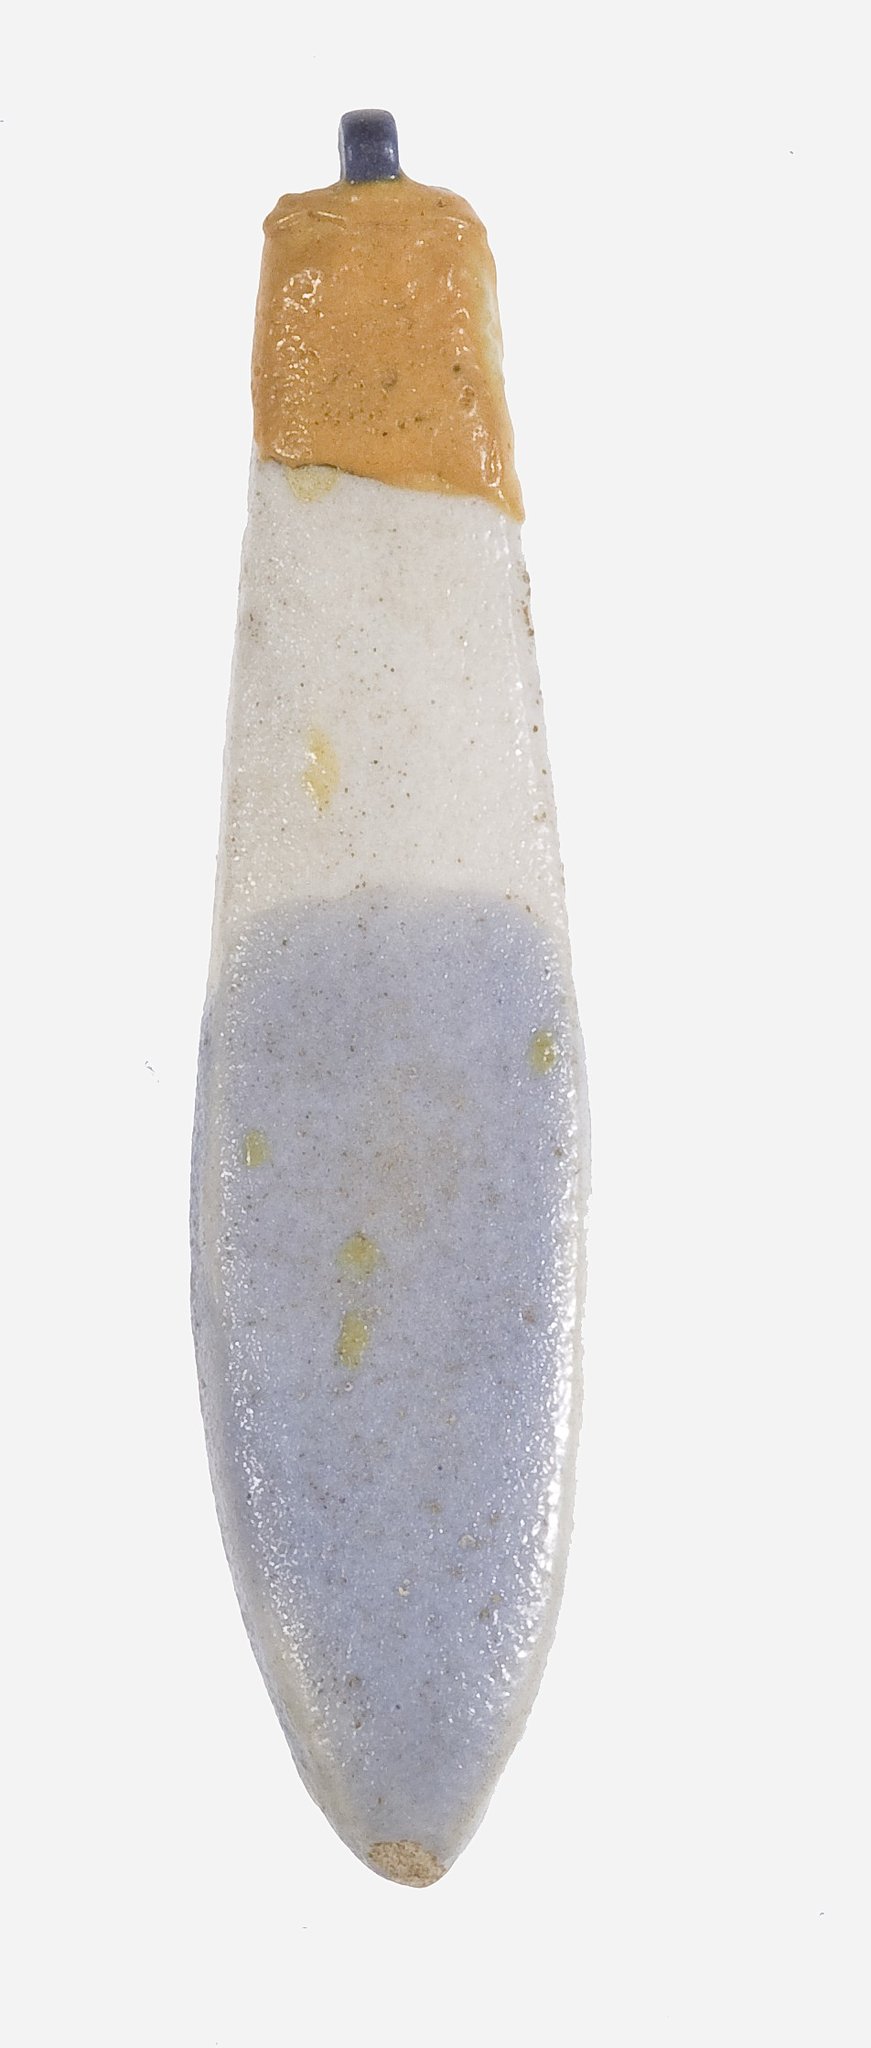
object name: bead, lotus petal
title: Bead in the Form of a Lotus Petal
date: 1390-1352 BCE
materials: faience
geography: egypt